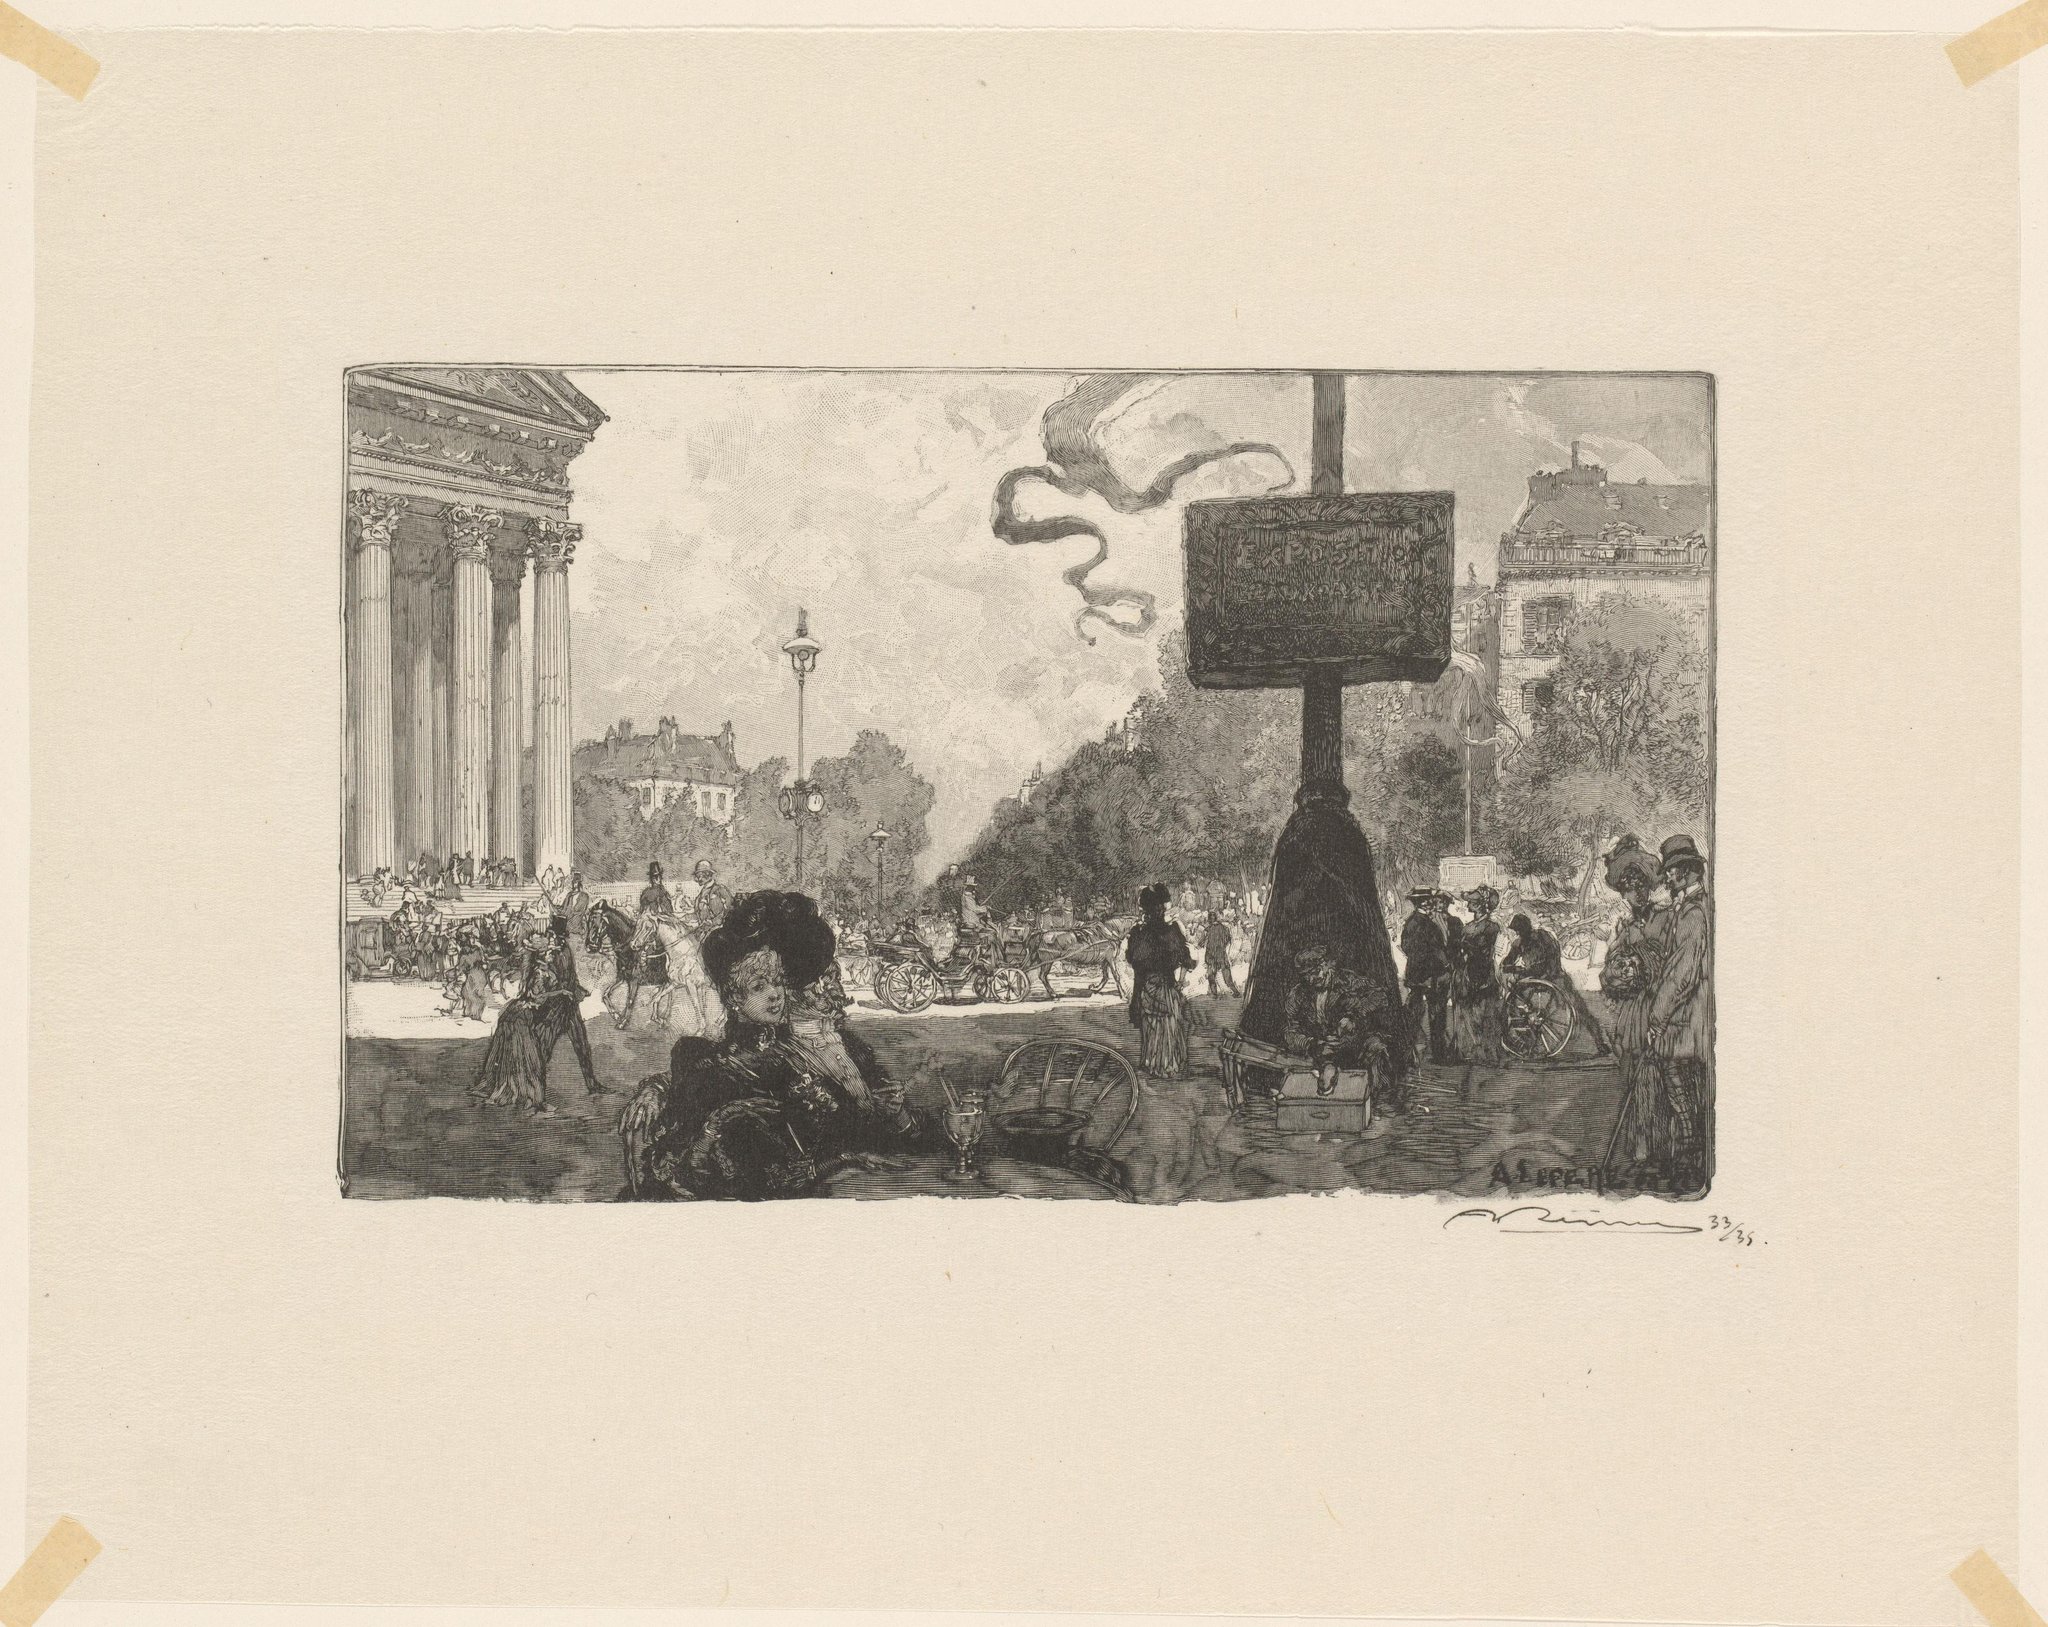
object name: print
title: L'Oeuvre gravé sur bois de Auguste Lepère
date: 1910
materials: paper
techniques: engraving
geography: paris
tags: square, place, circus, etc., prospect of city, town panorama, silhouette of city, paris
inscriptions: collector's mark: Lugt 2228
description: Deze serie heeft als titel 'Le long de la Seine et des boulevards'. Deze serie is het vierde deel van het grotere geheel 'L'Oeuvre gravé sur bois de Auguste Lepère'.